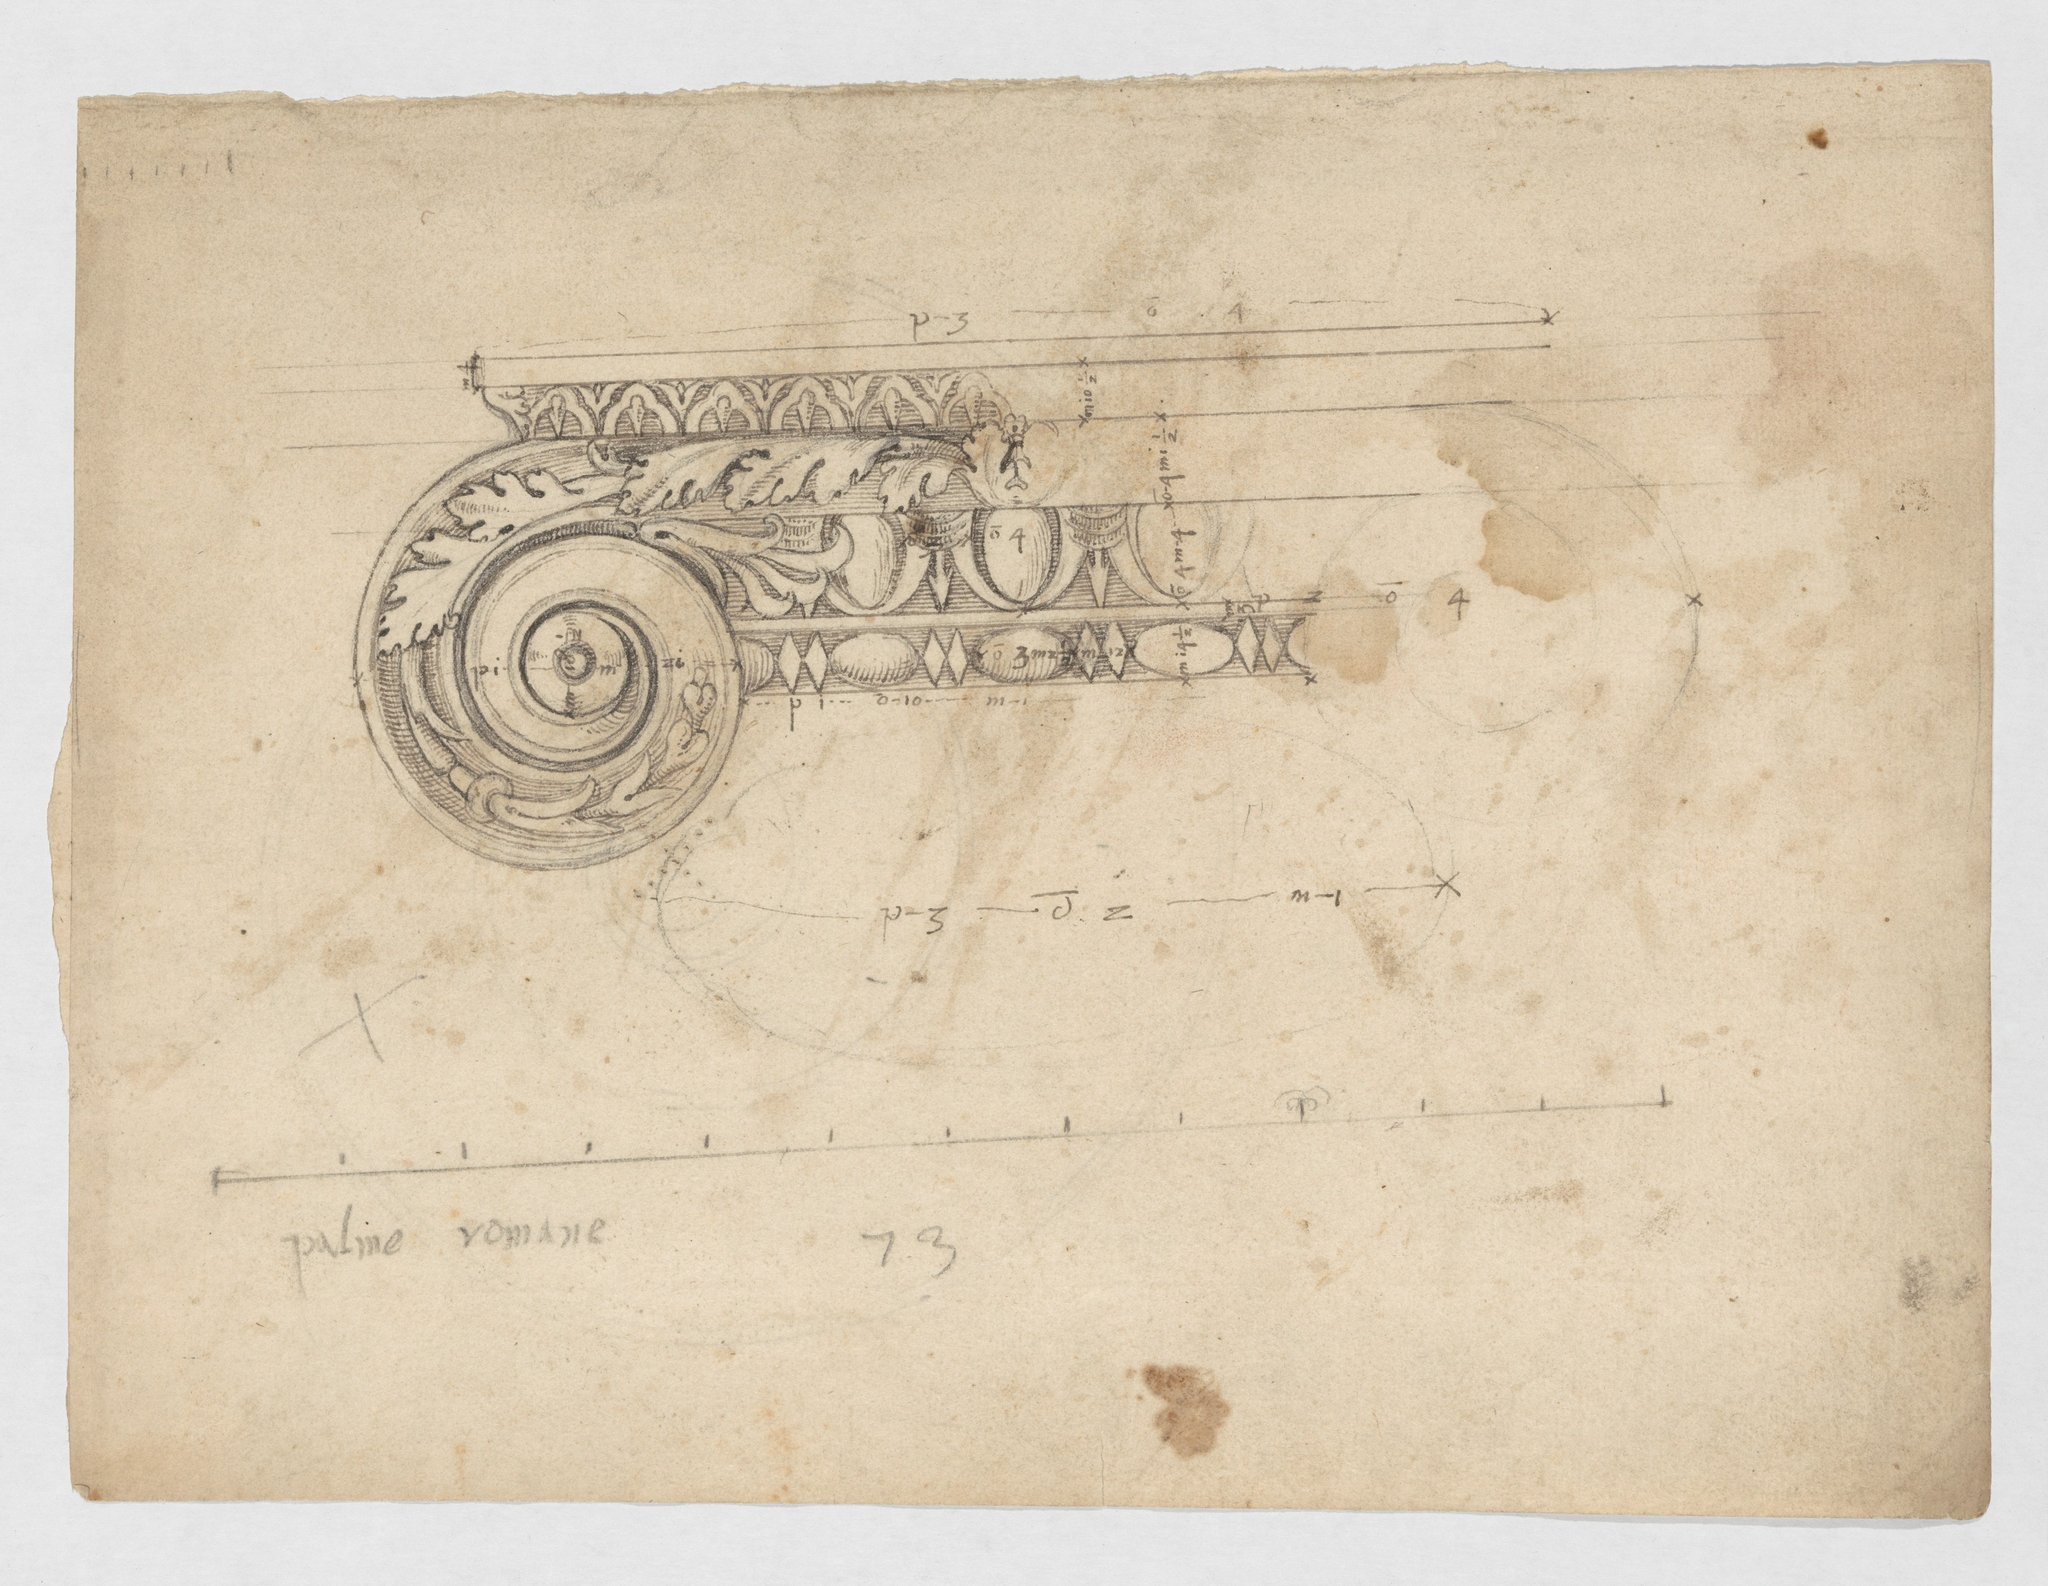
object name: collection ornament architecture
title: S. Maria in Trastevere, Ionic capital, volute, side elevation (recto) Unidentified, Ionic capital volute, construction diagram (verso)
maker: anonymous, french, 16th century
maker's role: draftsman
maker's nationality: french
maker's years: 1500-1600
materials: chalk, ink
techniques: incising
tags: capitals